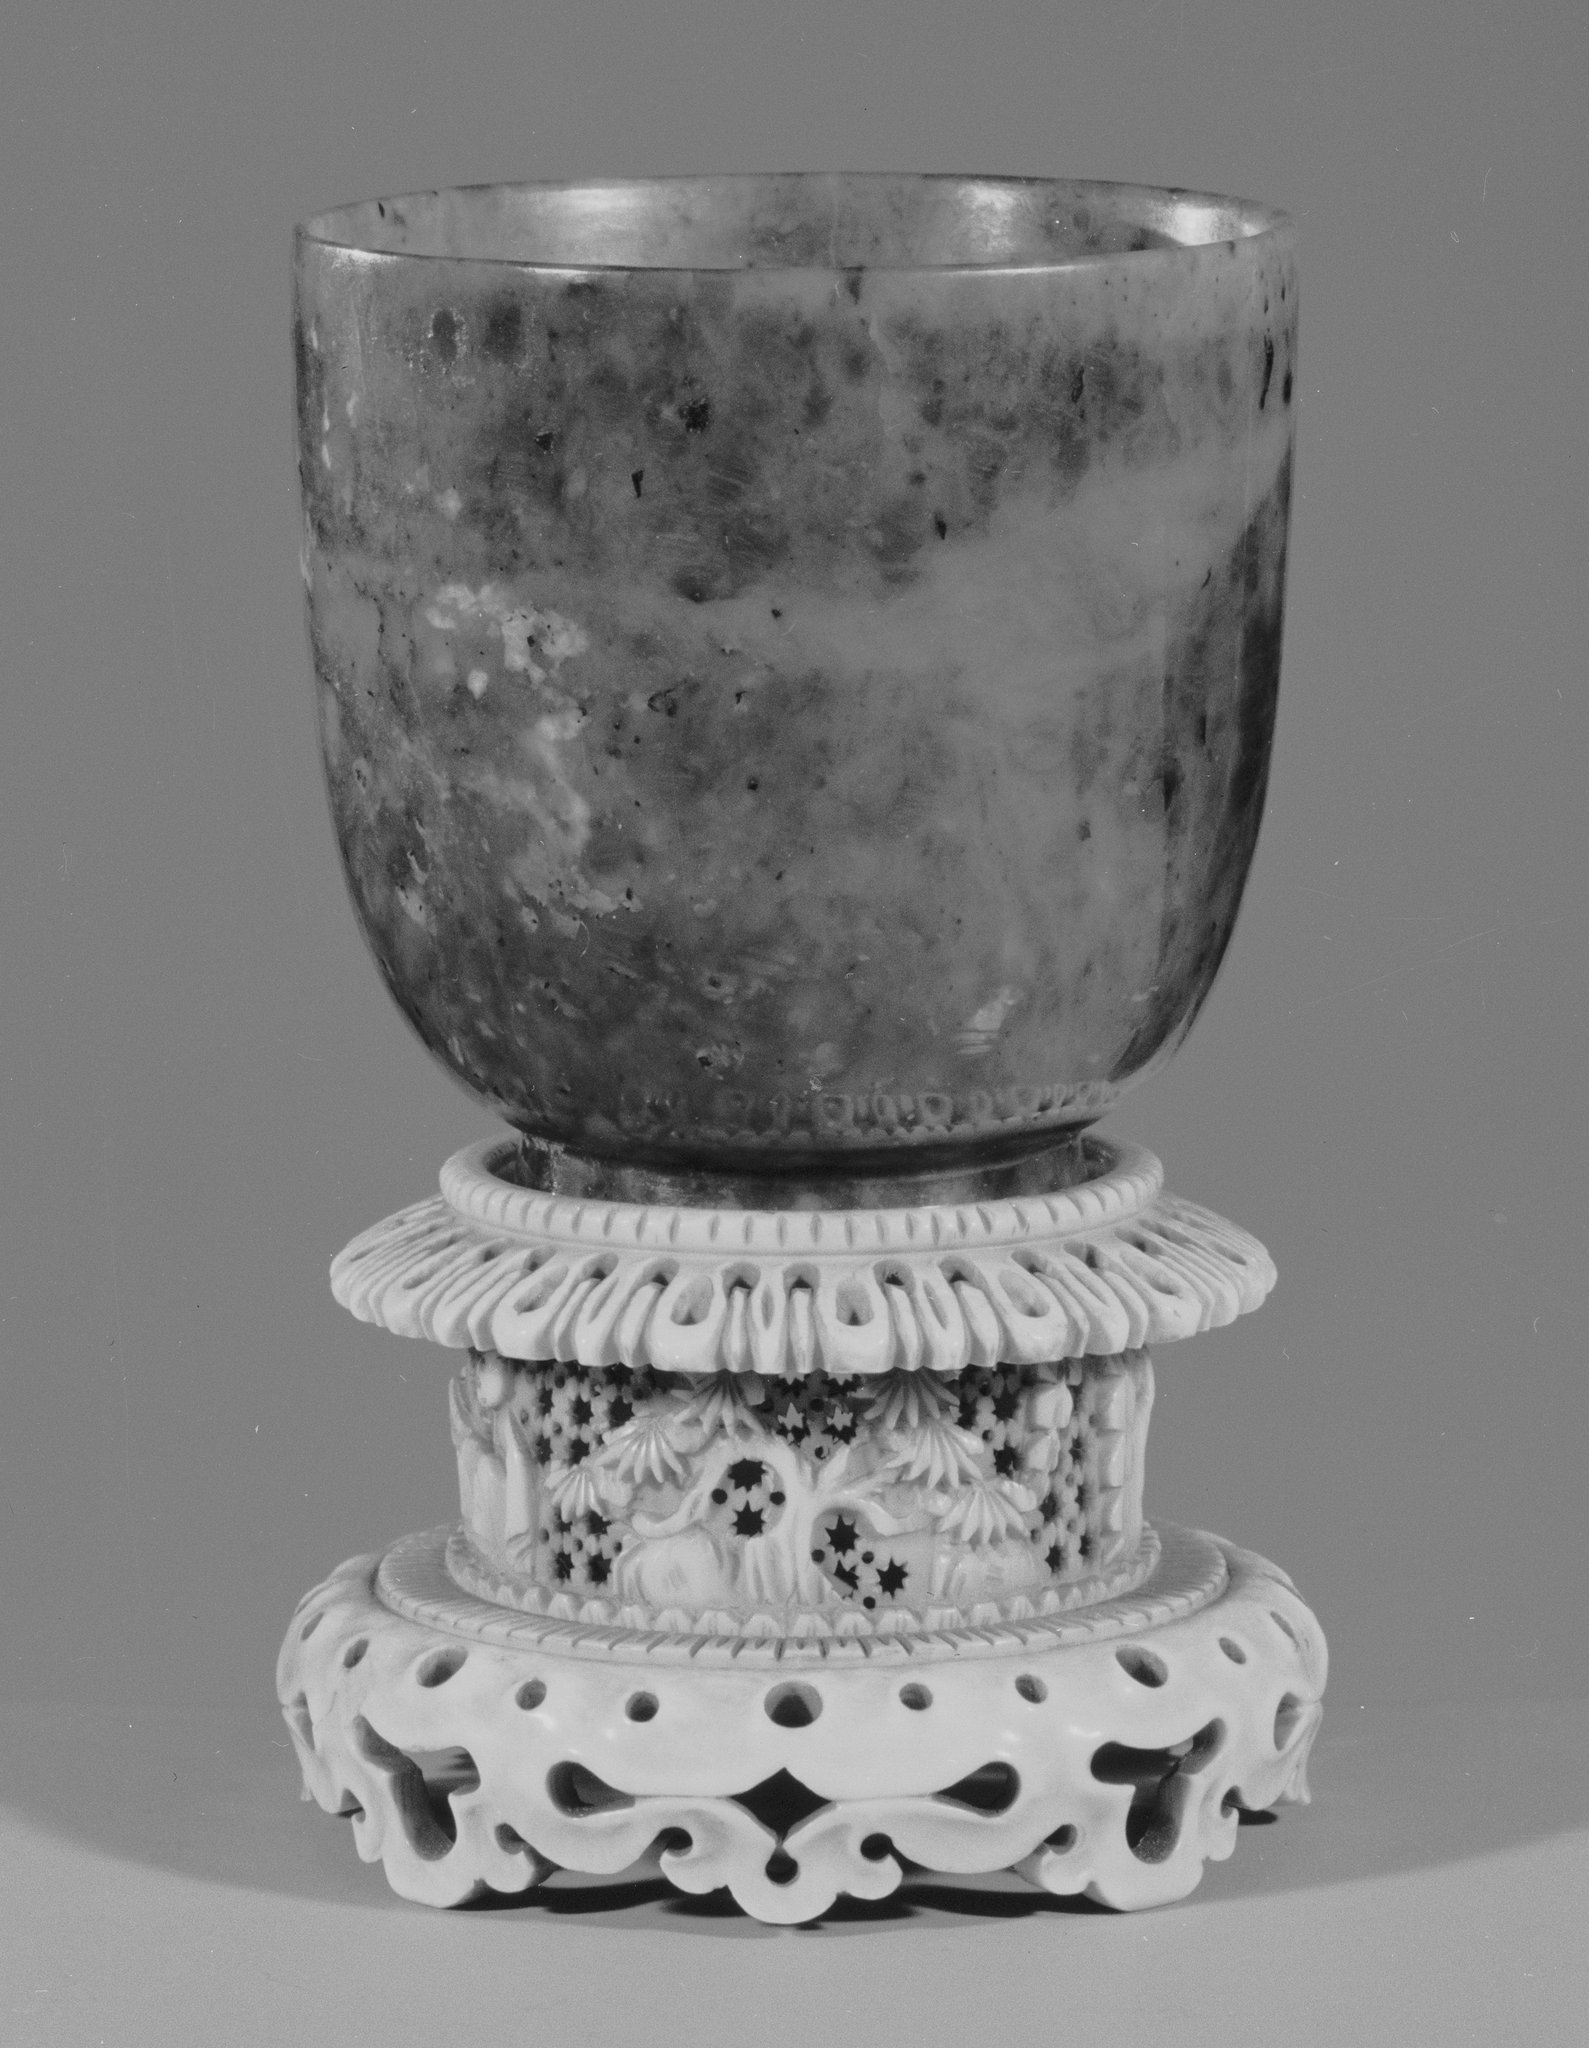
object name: cup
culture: chinese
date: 1867-1900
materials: ivory, jade